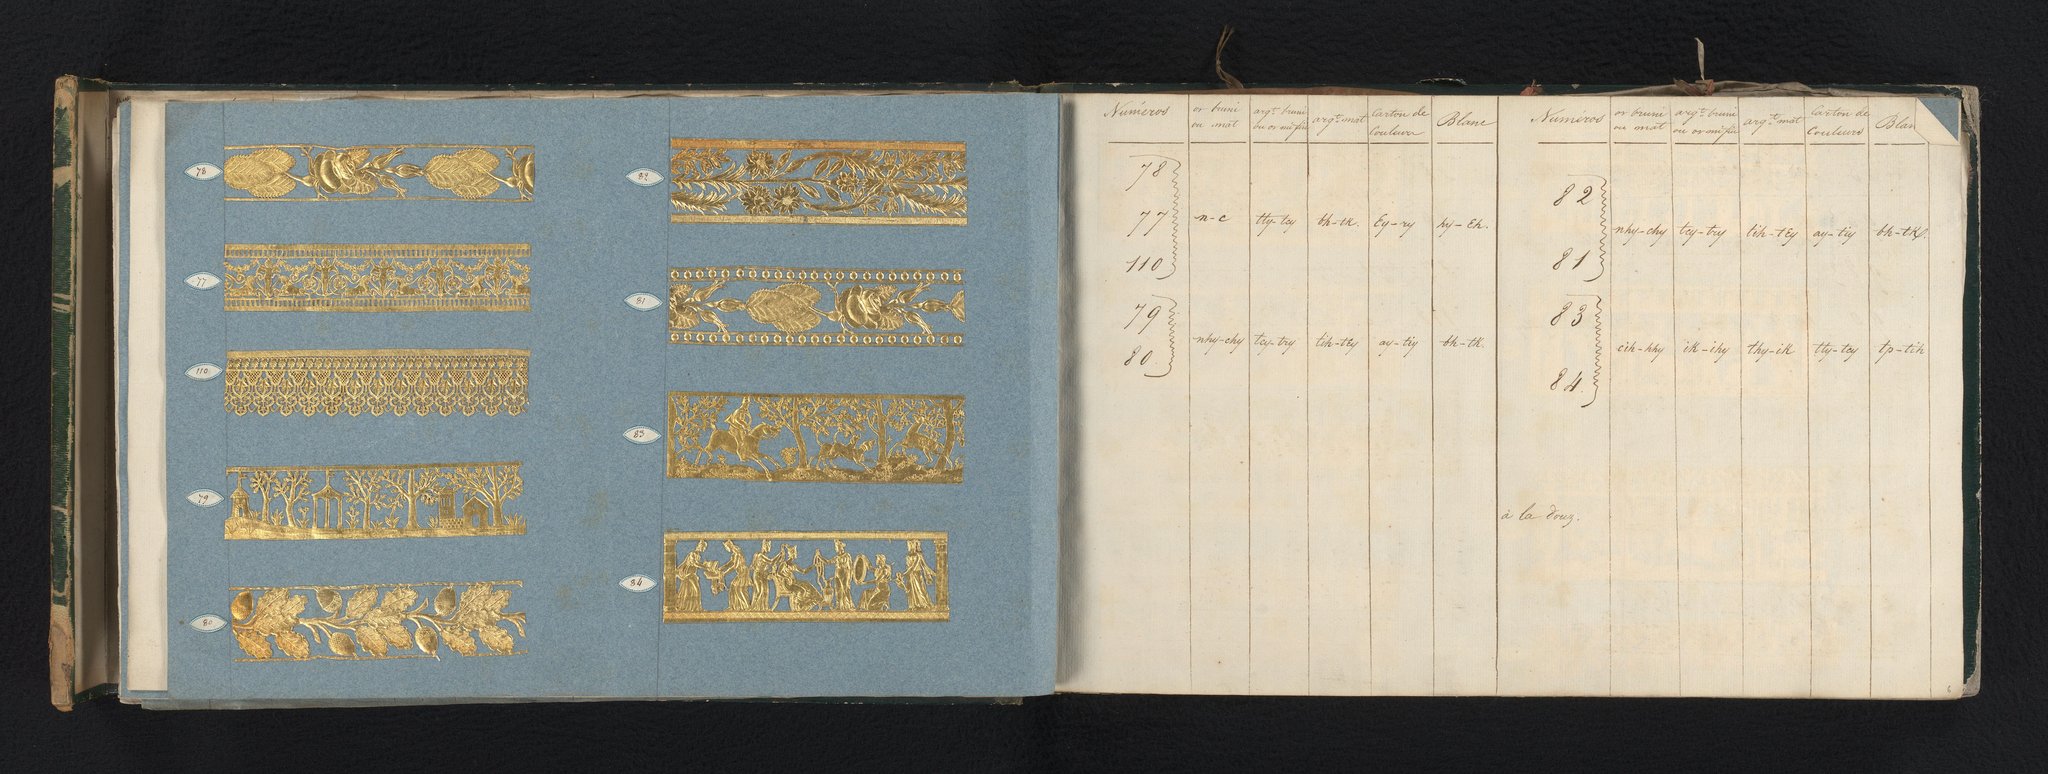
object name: sample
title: Twee bladzijden met stalen van sierlijsten van goudkleurig metaalpapier en bijbehorend tabel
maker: Anonymous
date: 1830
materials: gold leaf, ink, paper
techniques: manufacturing, writing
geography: france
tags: ornaments ~ art, stag-hunting, flowers: rose, making toilet - aa - (for) women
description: Twee bladzijden met links 9 opgeplakte en met etiketten genummerde (78-84) stalen van sierlijsten van goudkleurig metaalpapier. Sierlijsten met figuratieve voorstellingen: rozen, eikenbladeren, jachtscène en een klassieke voorstelling van een vrouw verzorgd door haar dienstmeiden. Op de tegenoverliggende rechterbladzijde een tabel met de handgeschreven corresponderende specificaties (in code) per ornament. Onderdeel van het stalenboek geschonken door de dames Van Rijn, vermoedelijk van een Franse papierfabrikant van luxe papieren, of diens vertegenwoordiger in Nederland, ca. 1830.